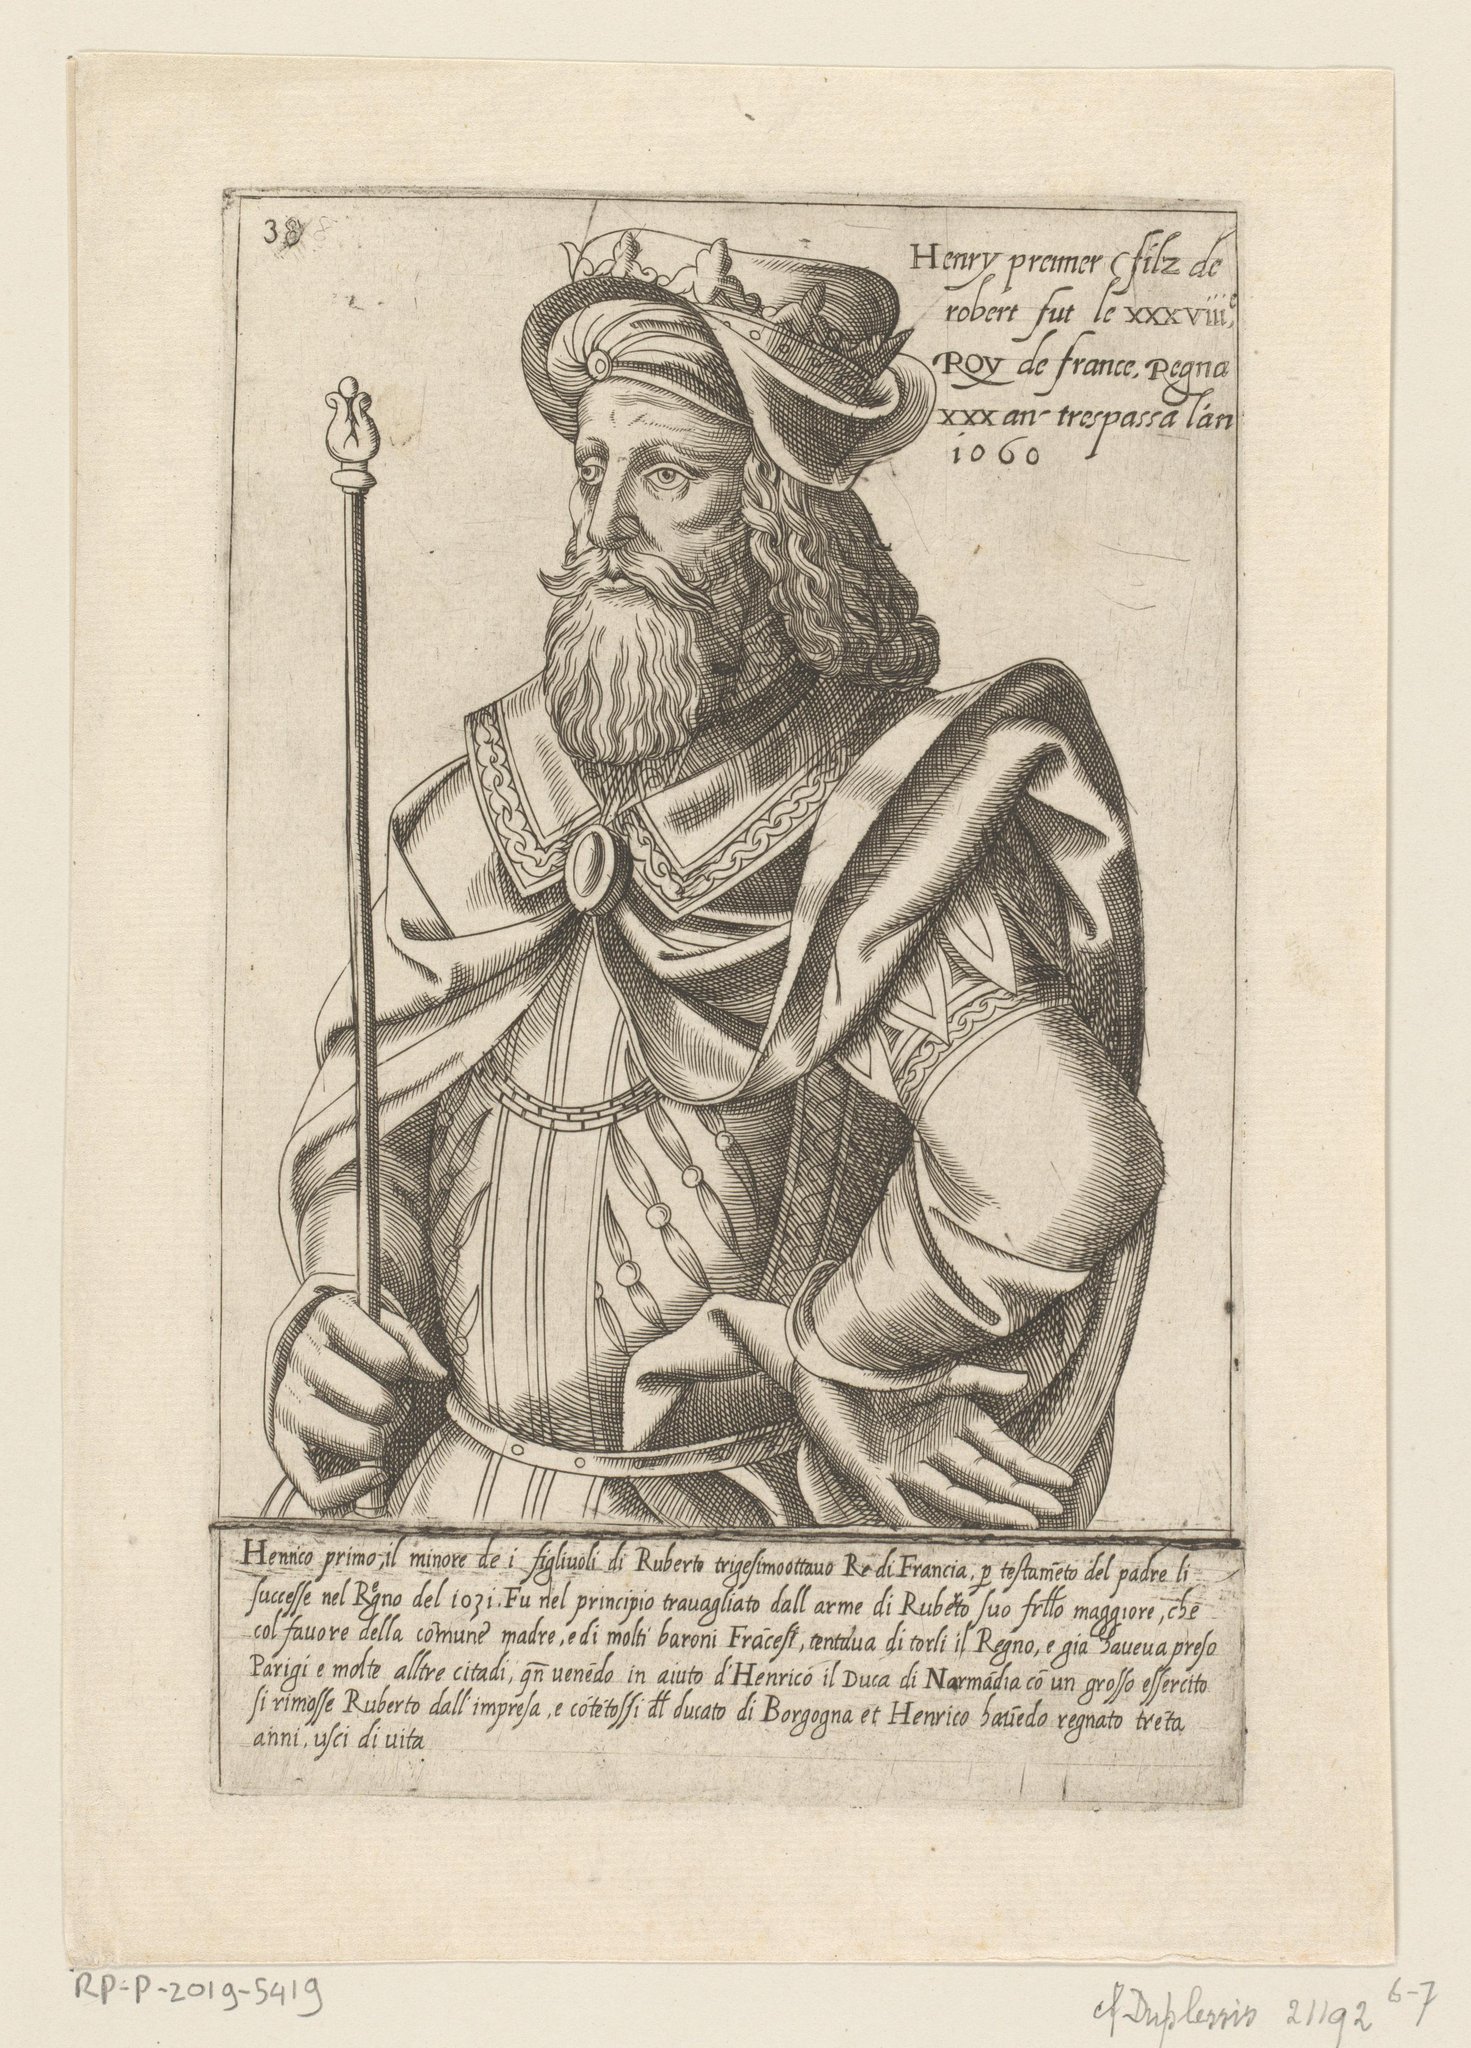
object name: print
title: Portret van Hendrik I, koning van Frankrijk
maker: Anonymous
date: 1588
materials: paper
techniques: engraving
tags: crown (symbol of sovereignty), sceptre, staff (symbol of sovereignty), historical persons, king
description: Prent voor het eerst gebruikt in: Cronica Breve de i fatti illustri de're di Francia, con le loro effigie dal naturale cominciando da Faramondo (...). Venetië: Bernardo Giunti, 1588. Prent in ieder geval ook gebruikt in de editie van 1590 en mogelijk ook in een Franse uitgave van 1597.